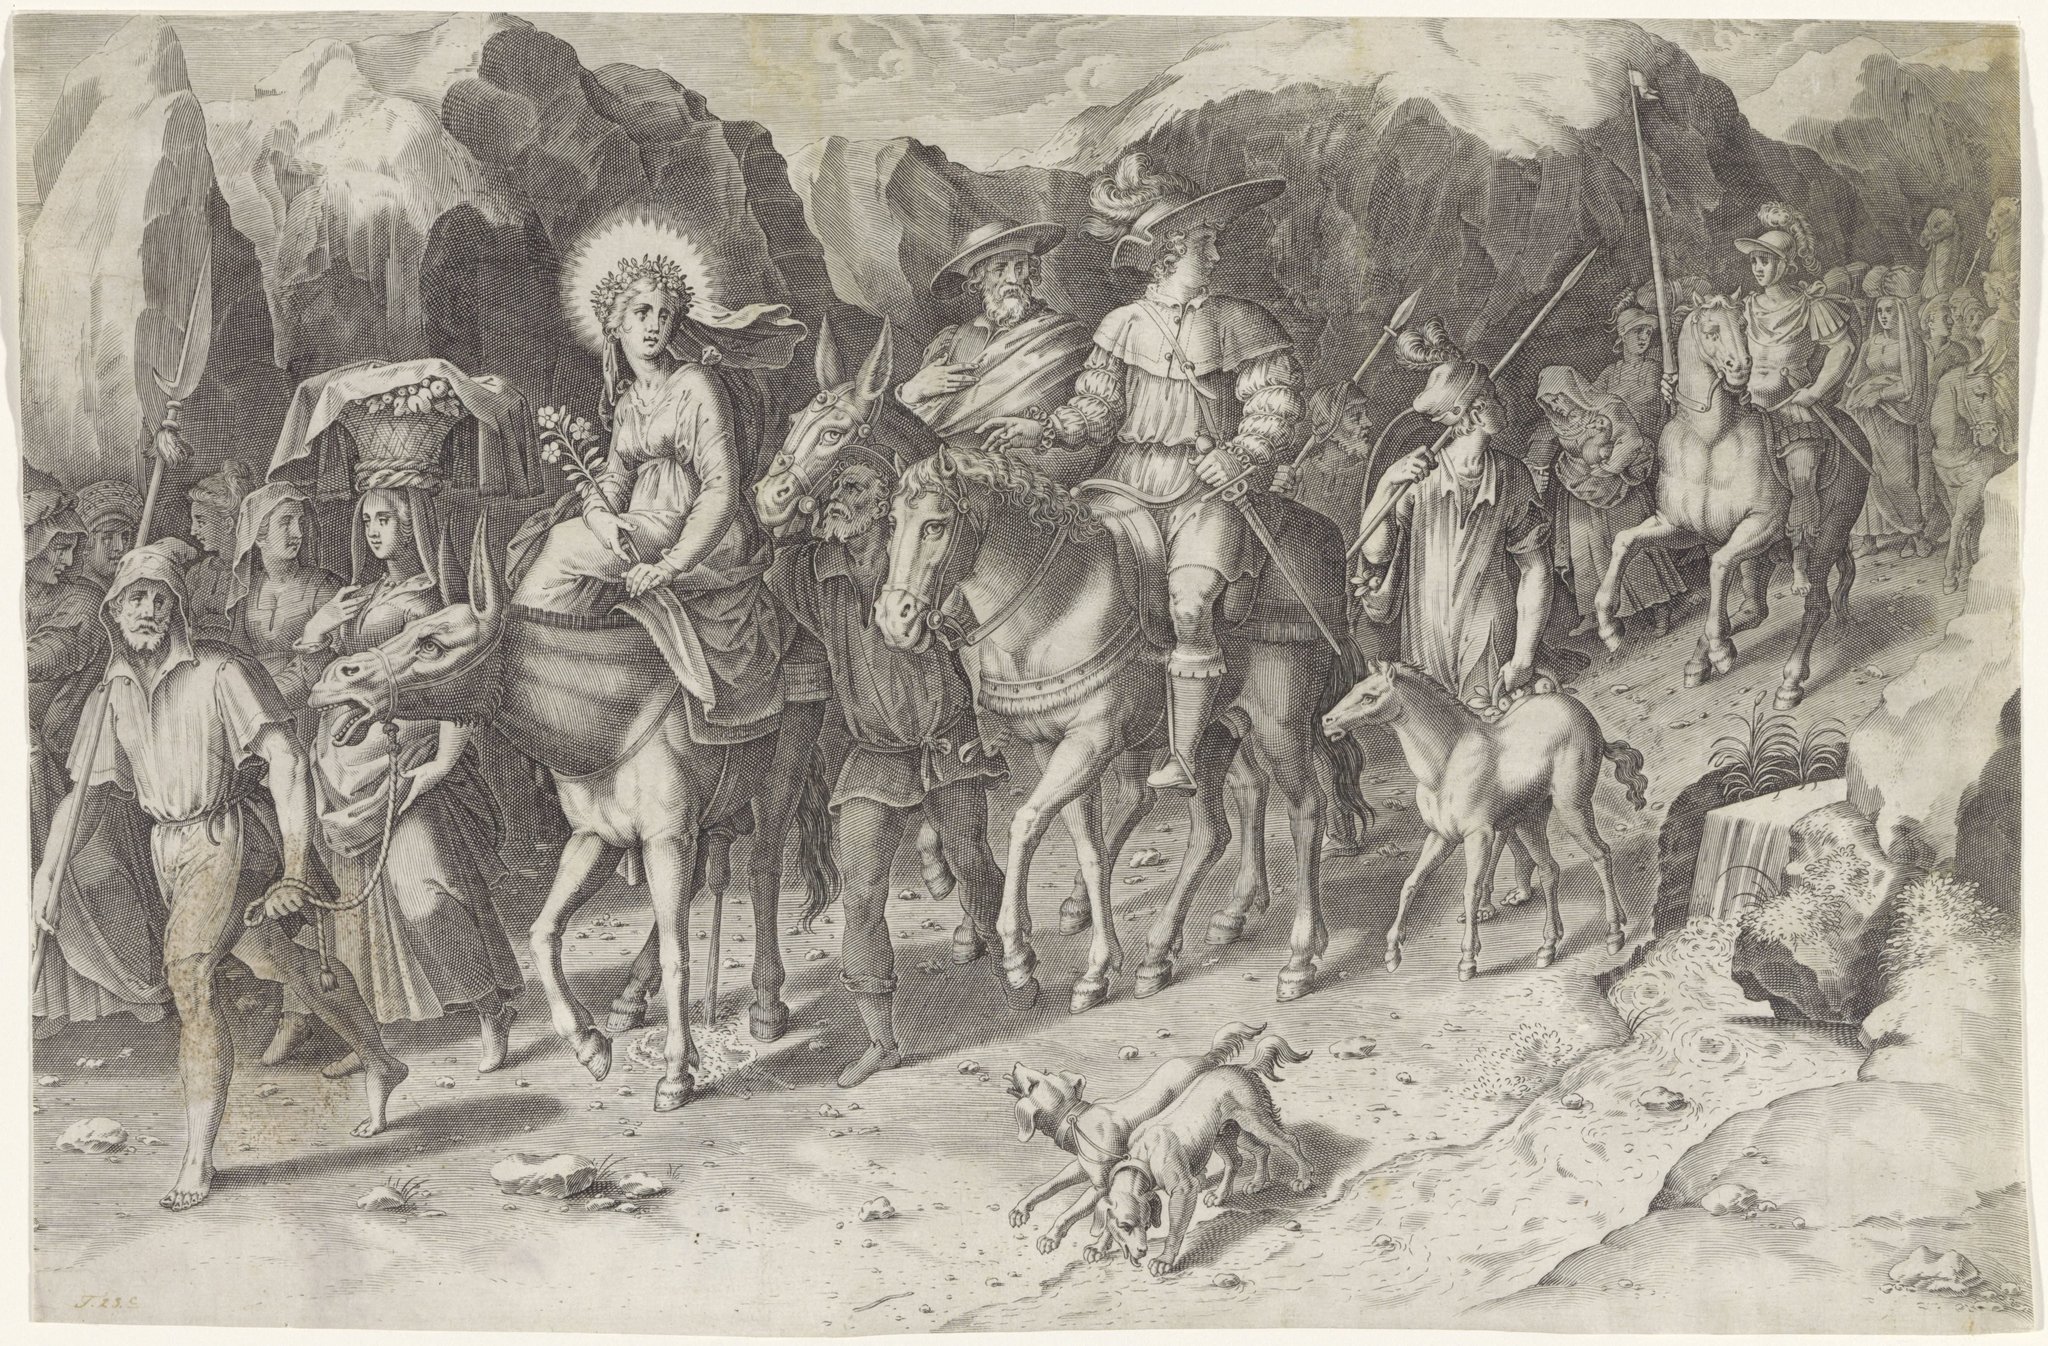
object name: print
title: Huwelijk van Isaak en Rebekka (blad 3)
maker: gijsbert van veen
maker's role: print maker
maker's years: 1562-1628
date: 1585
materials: paper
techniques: engraving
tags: marriage of isaac and rebekah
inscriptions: collector's mark: Lugt 2228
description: Rechter middenblad van een voorstelling van het huwelijk van Isaak en Rebekka, bestaande uit vier bladen gedrukt van vier platen.